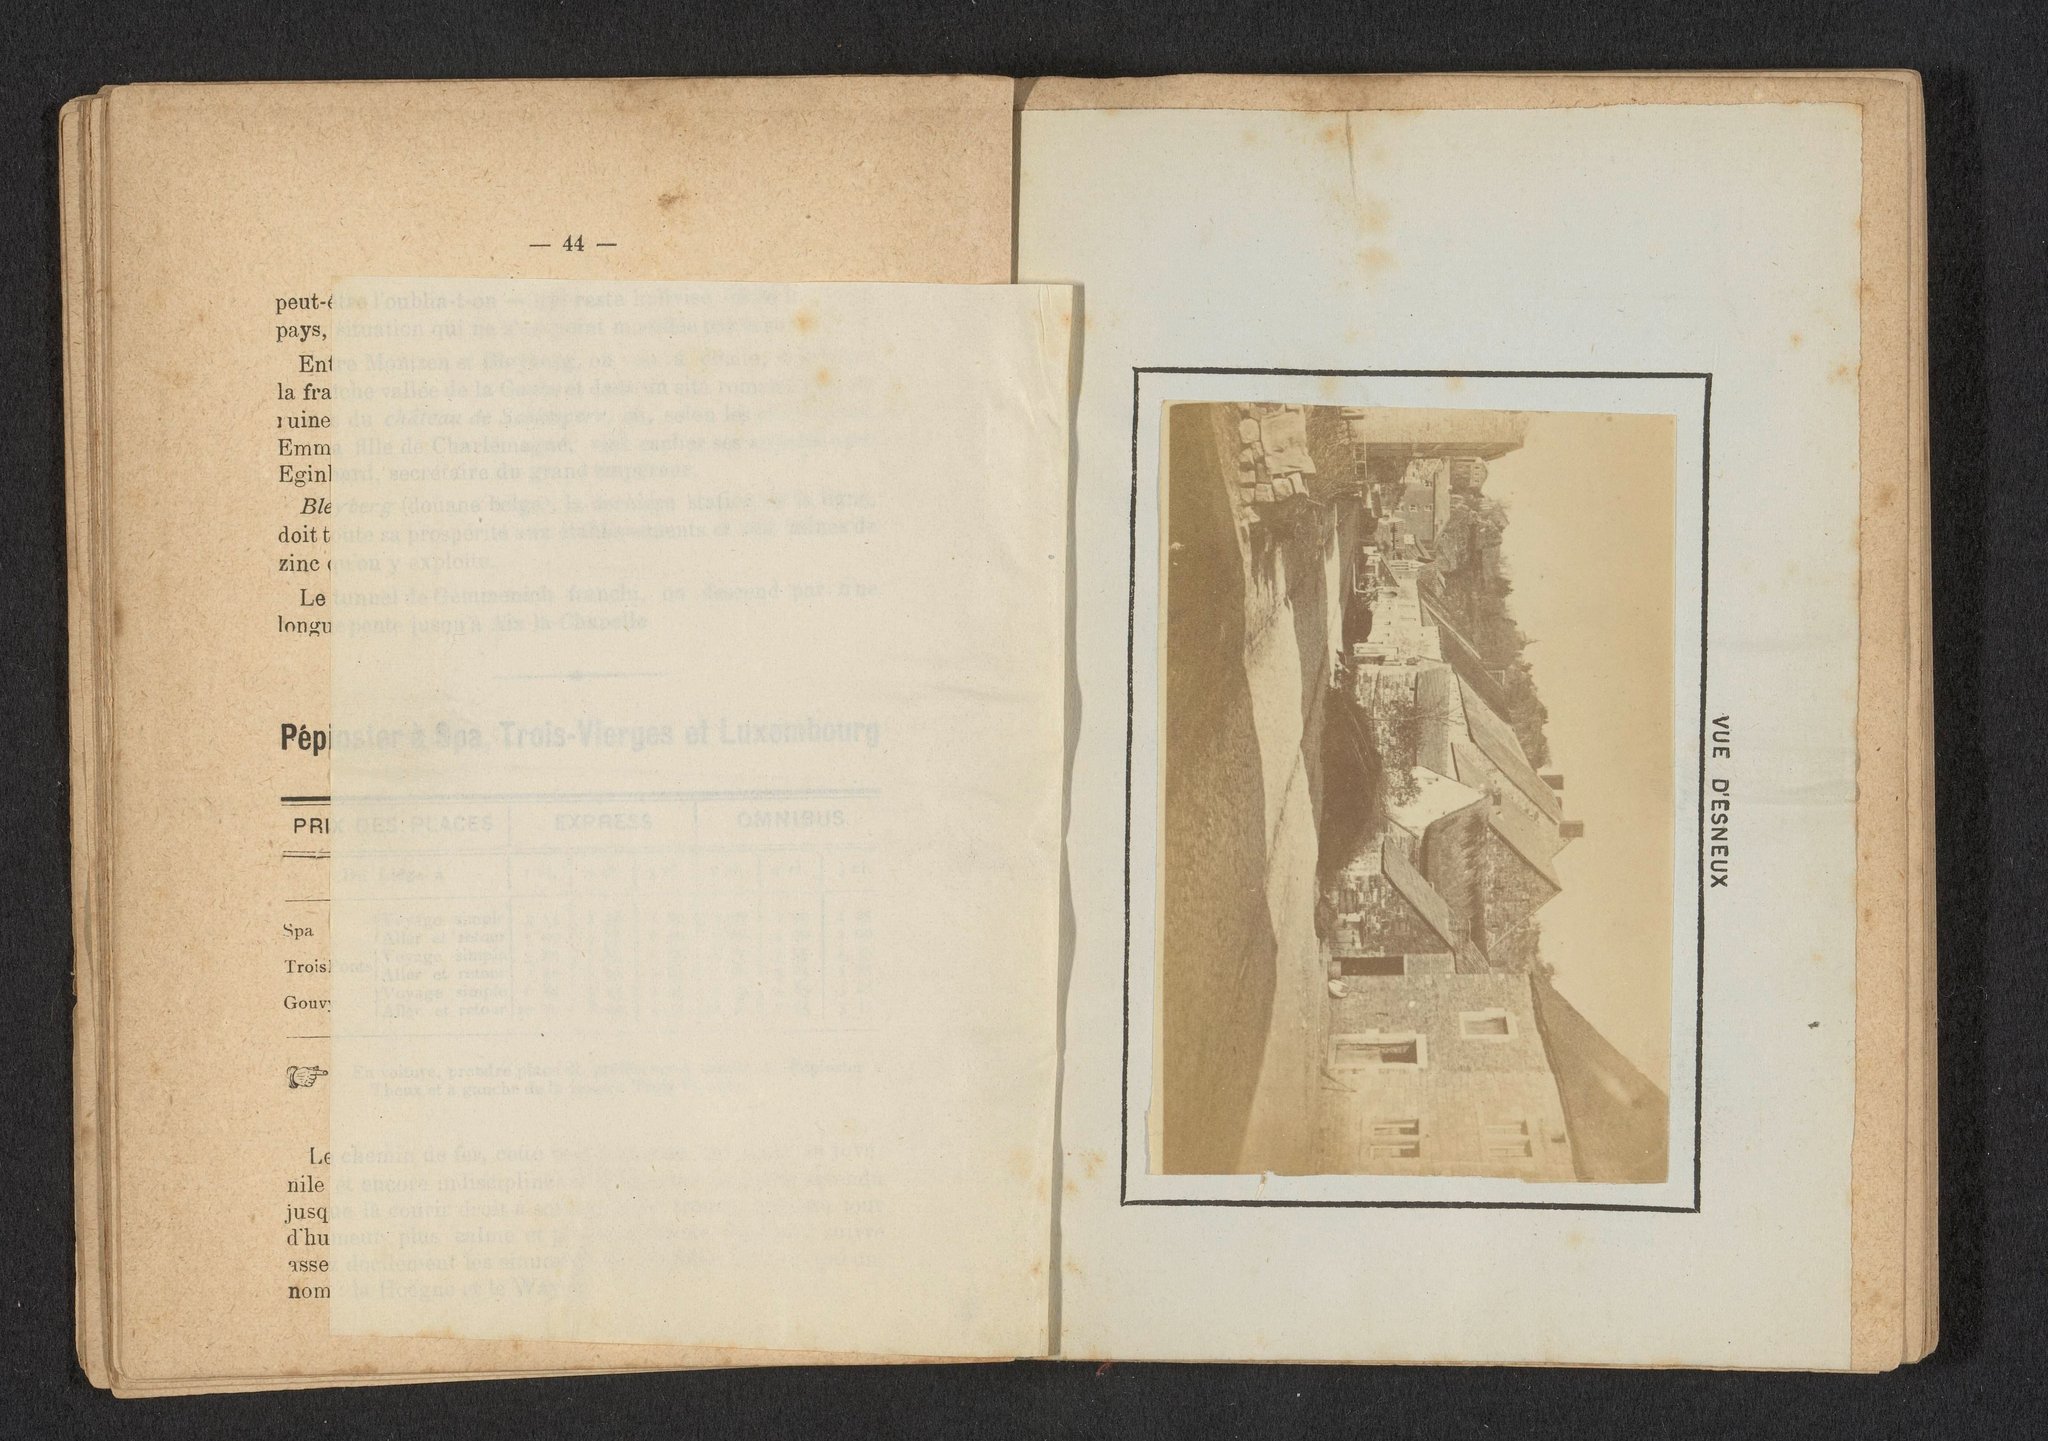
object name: photograph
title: Gezicht op Esneux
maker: Anonymous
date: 1876-1881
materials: photographic support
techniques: albumen print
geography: esneux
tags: city-view in general; 'veduta'